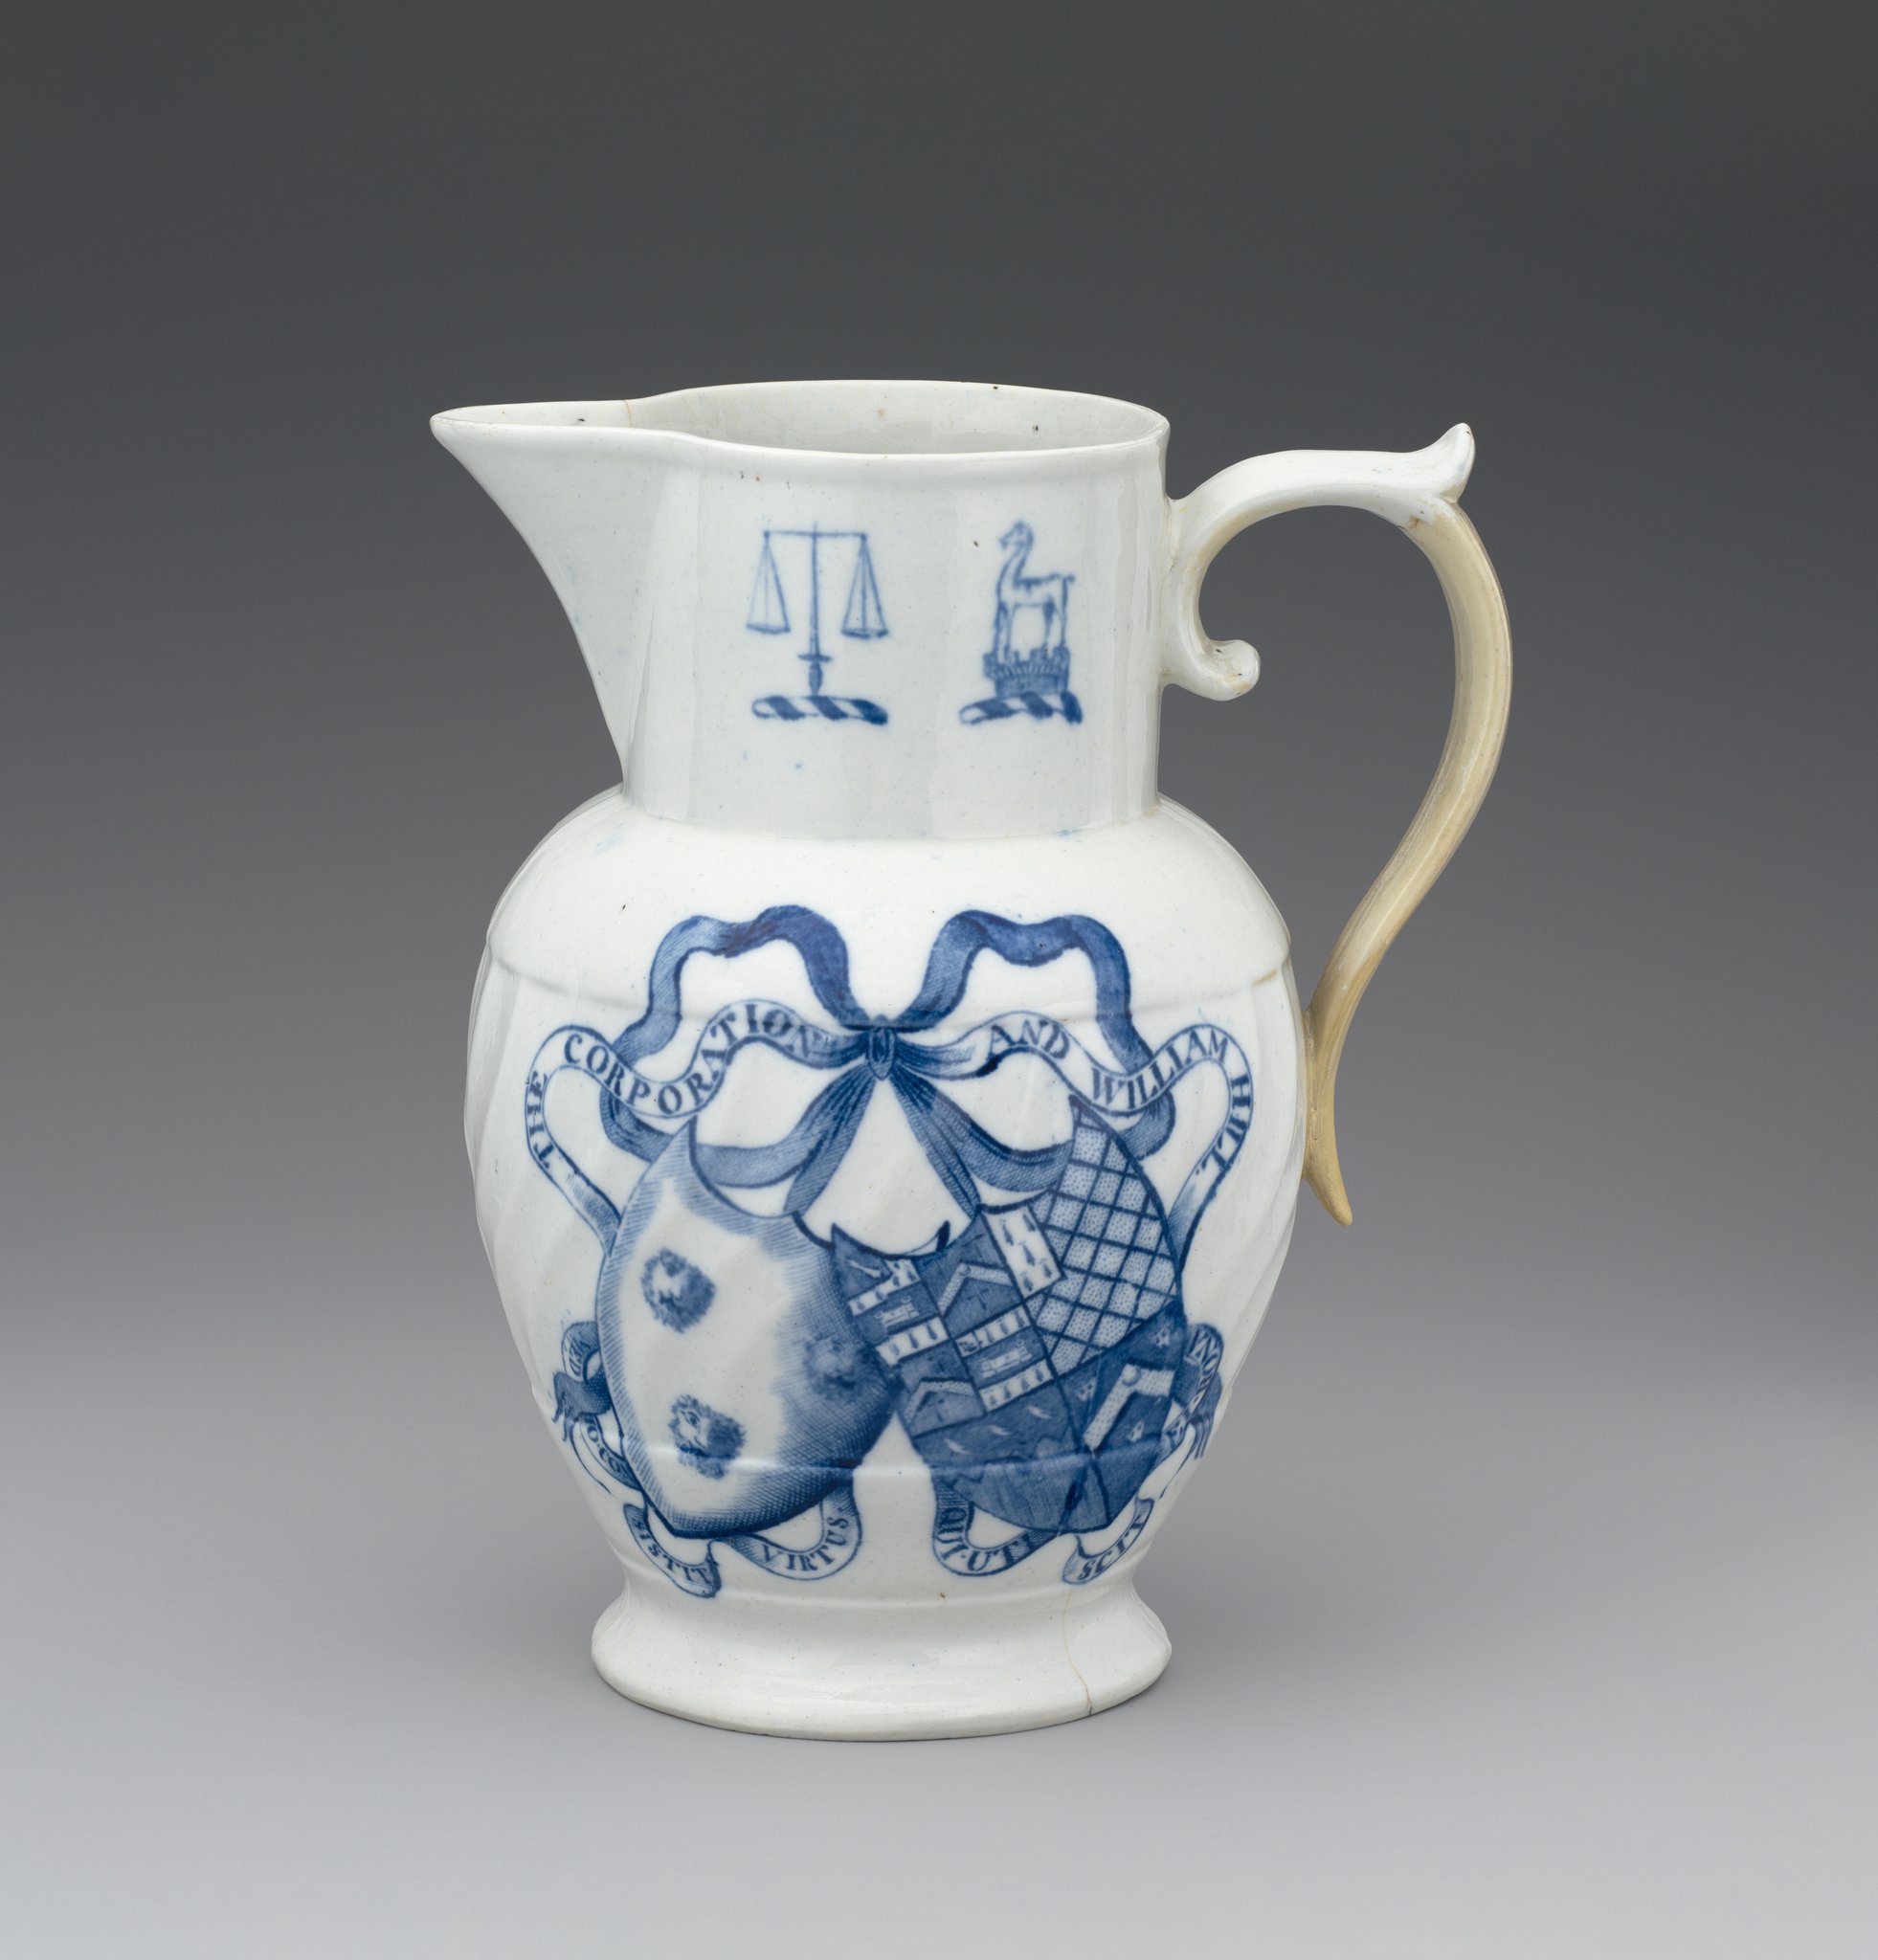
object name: jug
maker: coalport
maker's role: factory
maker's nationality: british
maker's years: 1794-1926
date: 1796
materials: soft paste porcelain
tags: coat of arms